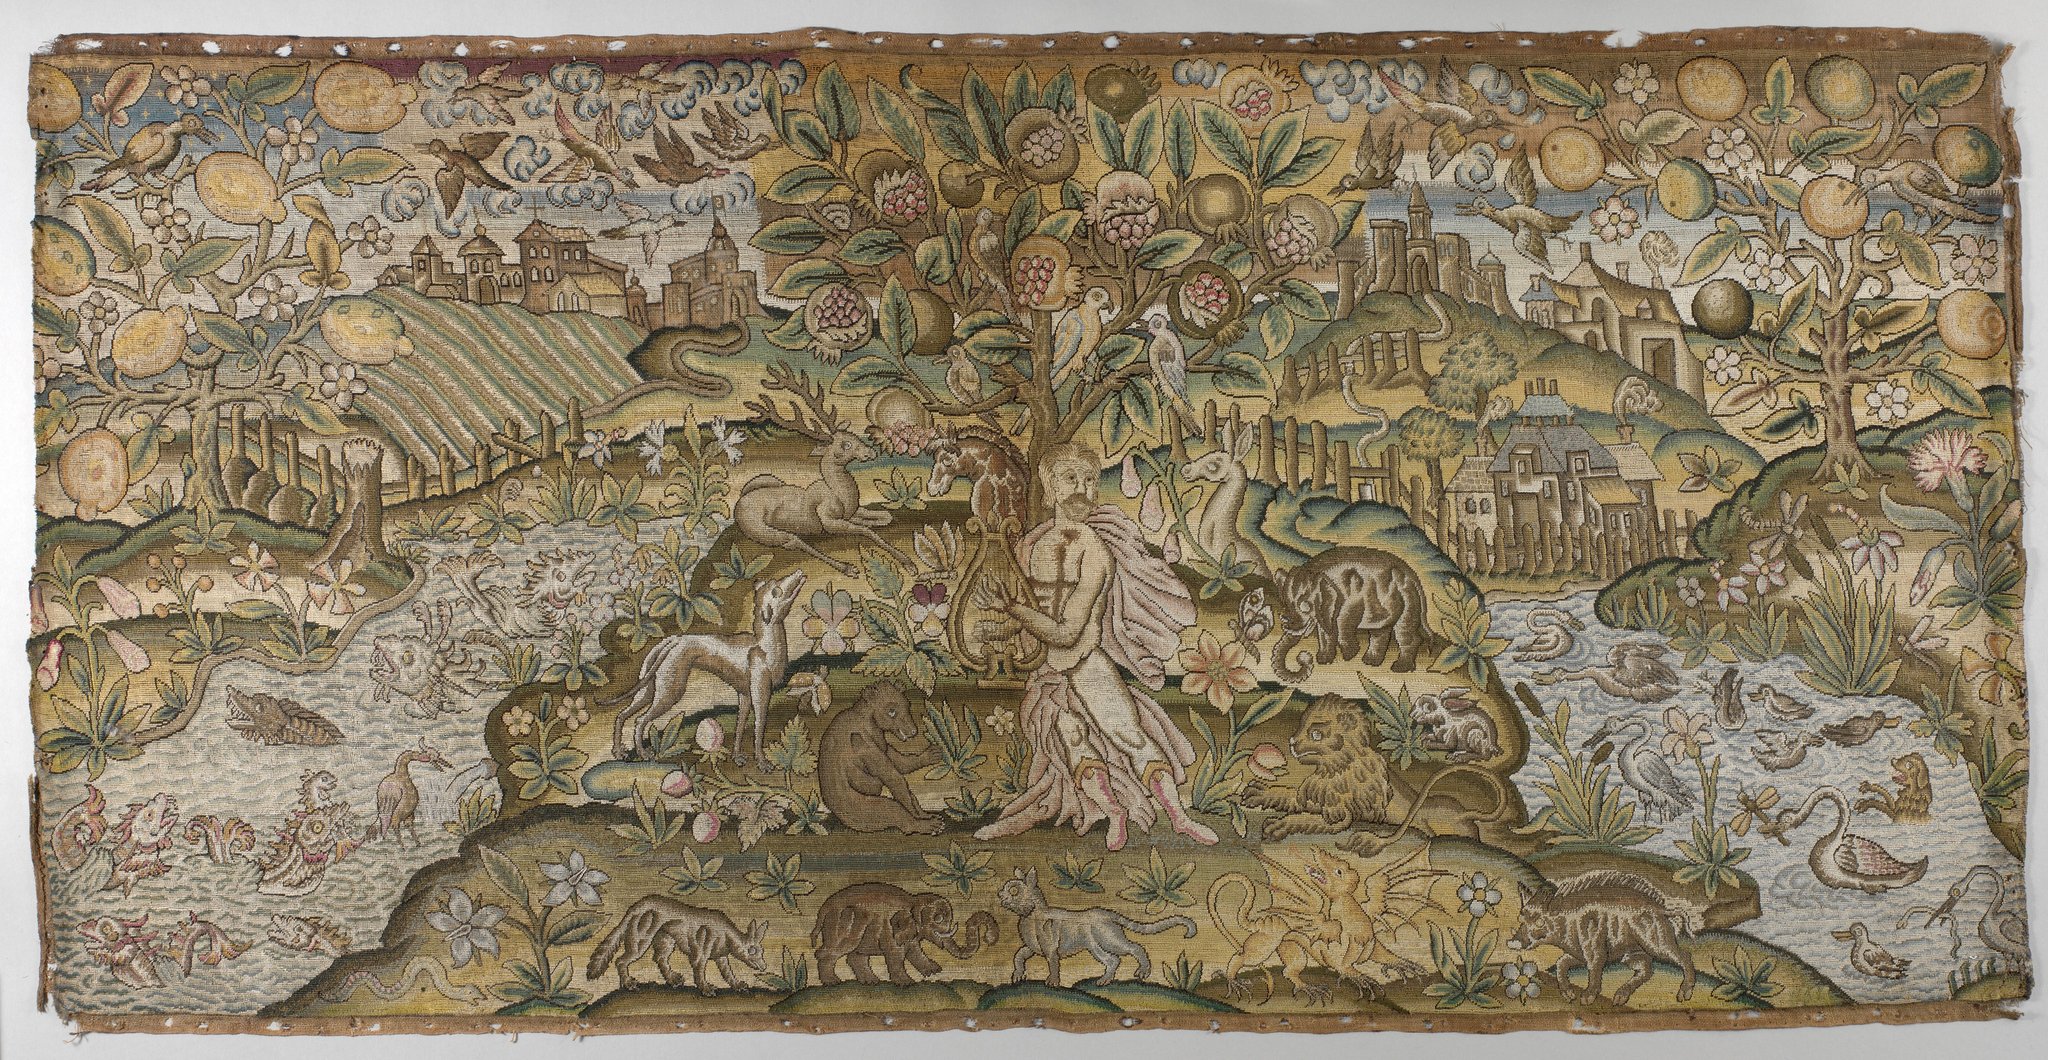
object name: embroidered picture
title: Orpheus Charming the Animals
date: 1626-1650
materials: canvas, thread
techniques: embroidery, stitching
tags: orpheus,swans,deer,elephants,lions